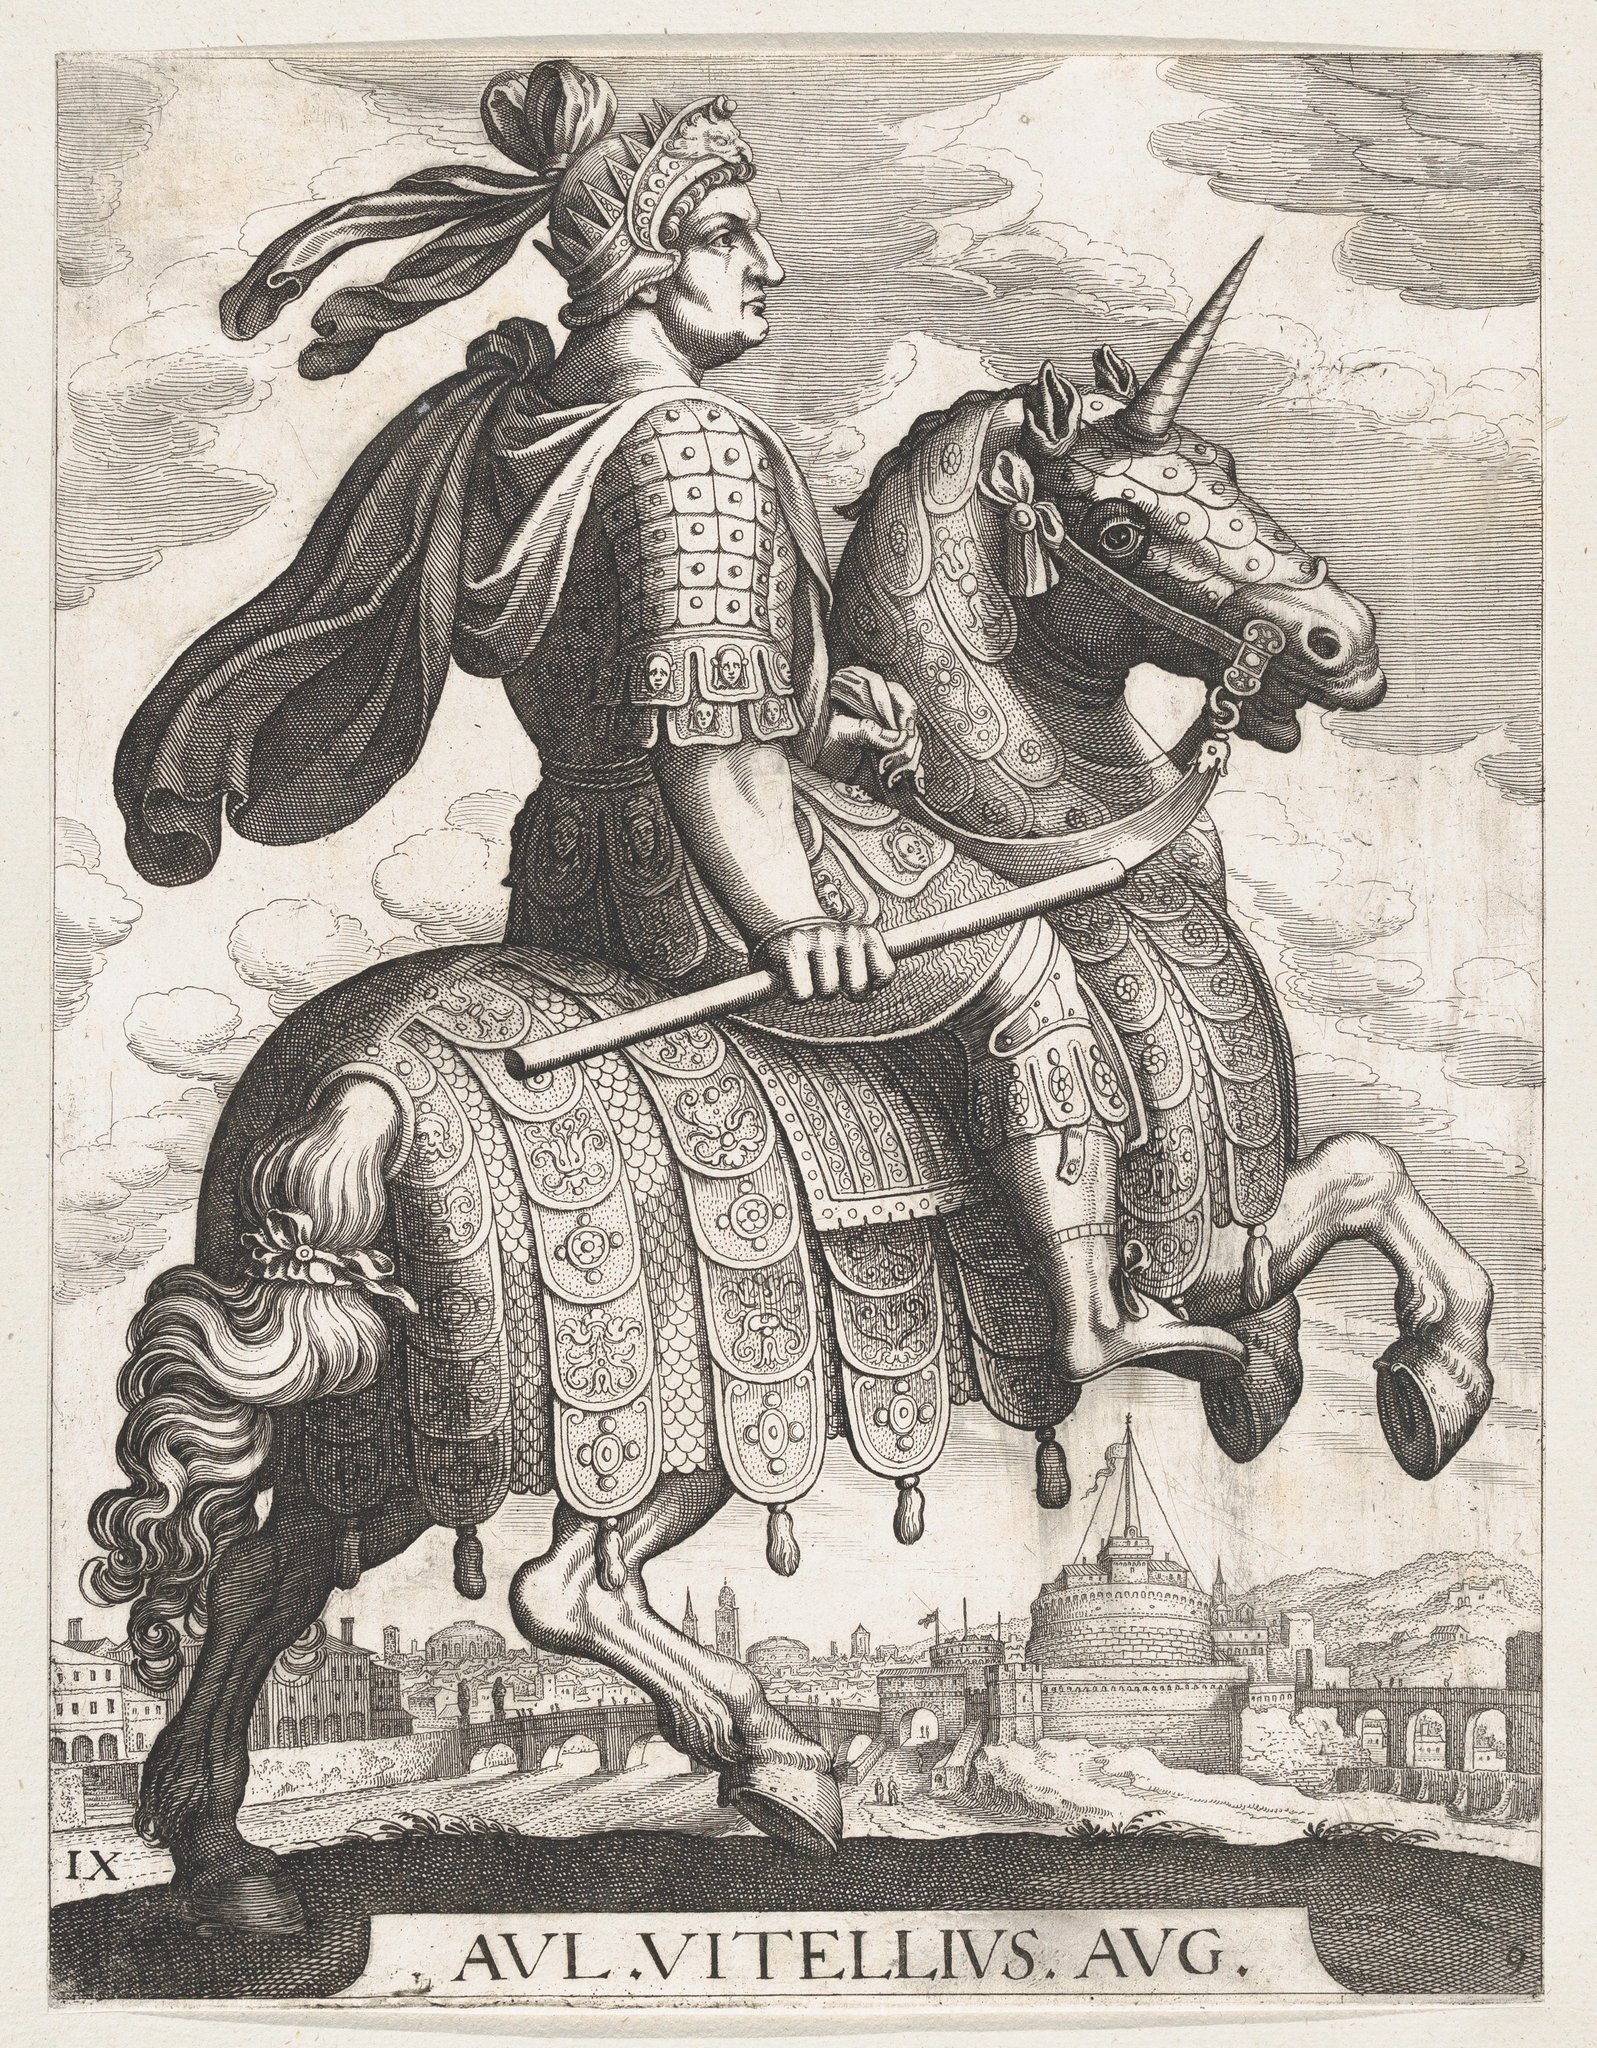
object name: print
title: Plate 9: Emperor Vitellus on Horseback, from 'The First Twelve Roman Caesars' after Tempesta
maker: matthäus merian the elder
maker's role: artist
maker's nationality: swiss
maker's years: 1593-1650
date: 1610-1650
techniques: engraving, etching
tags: men,horses